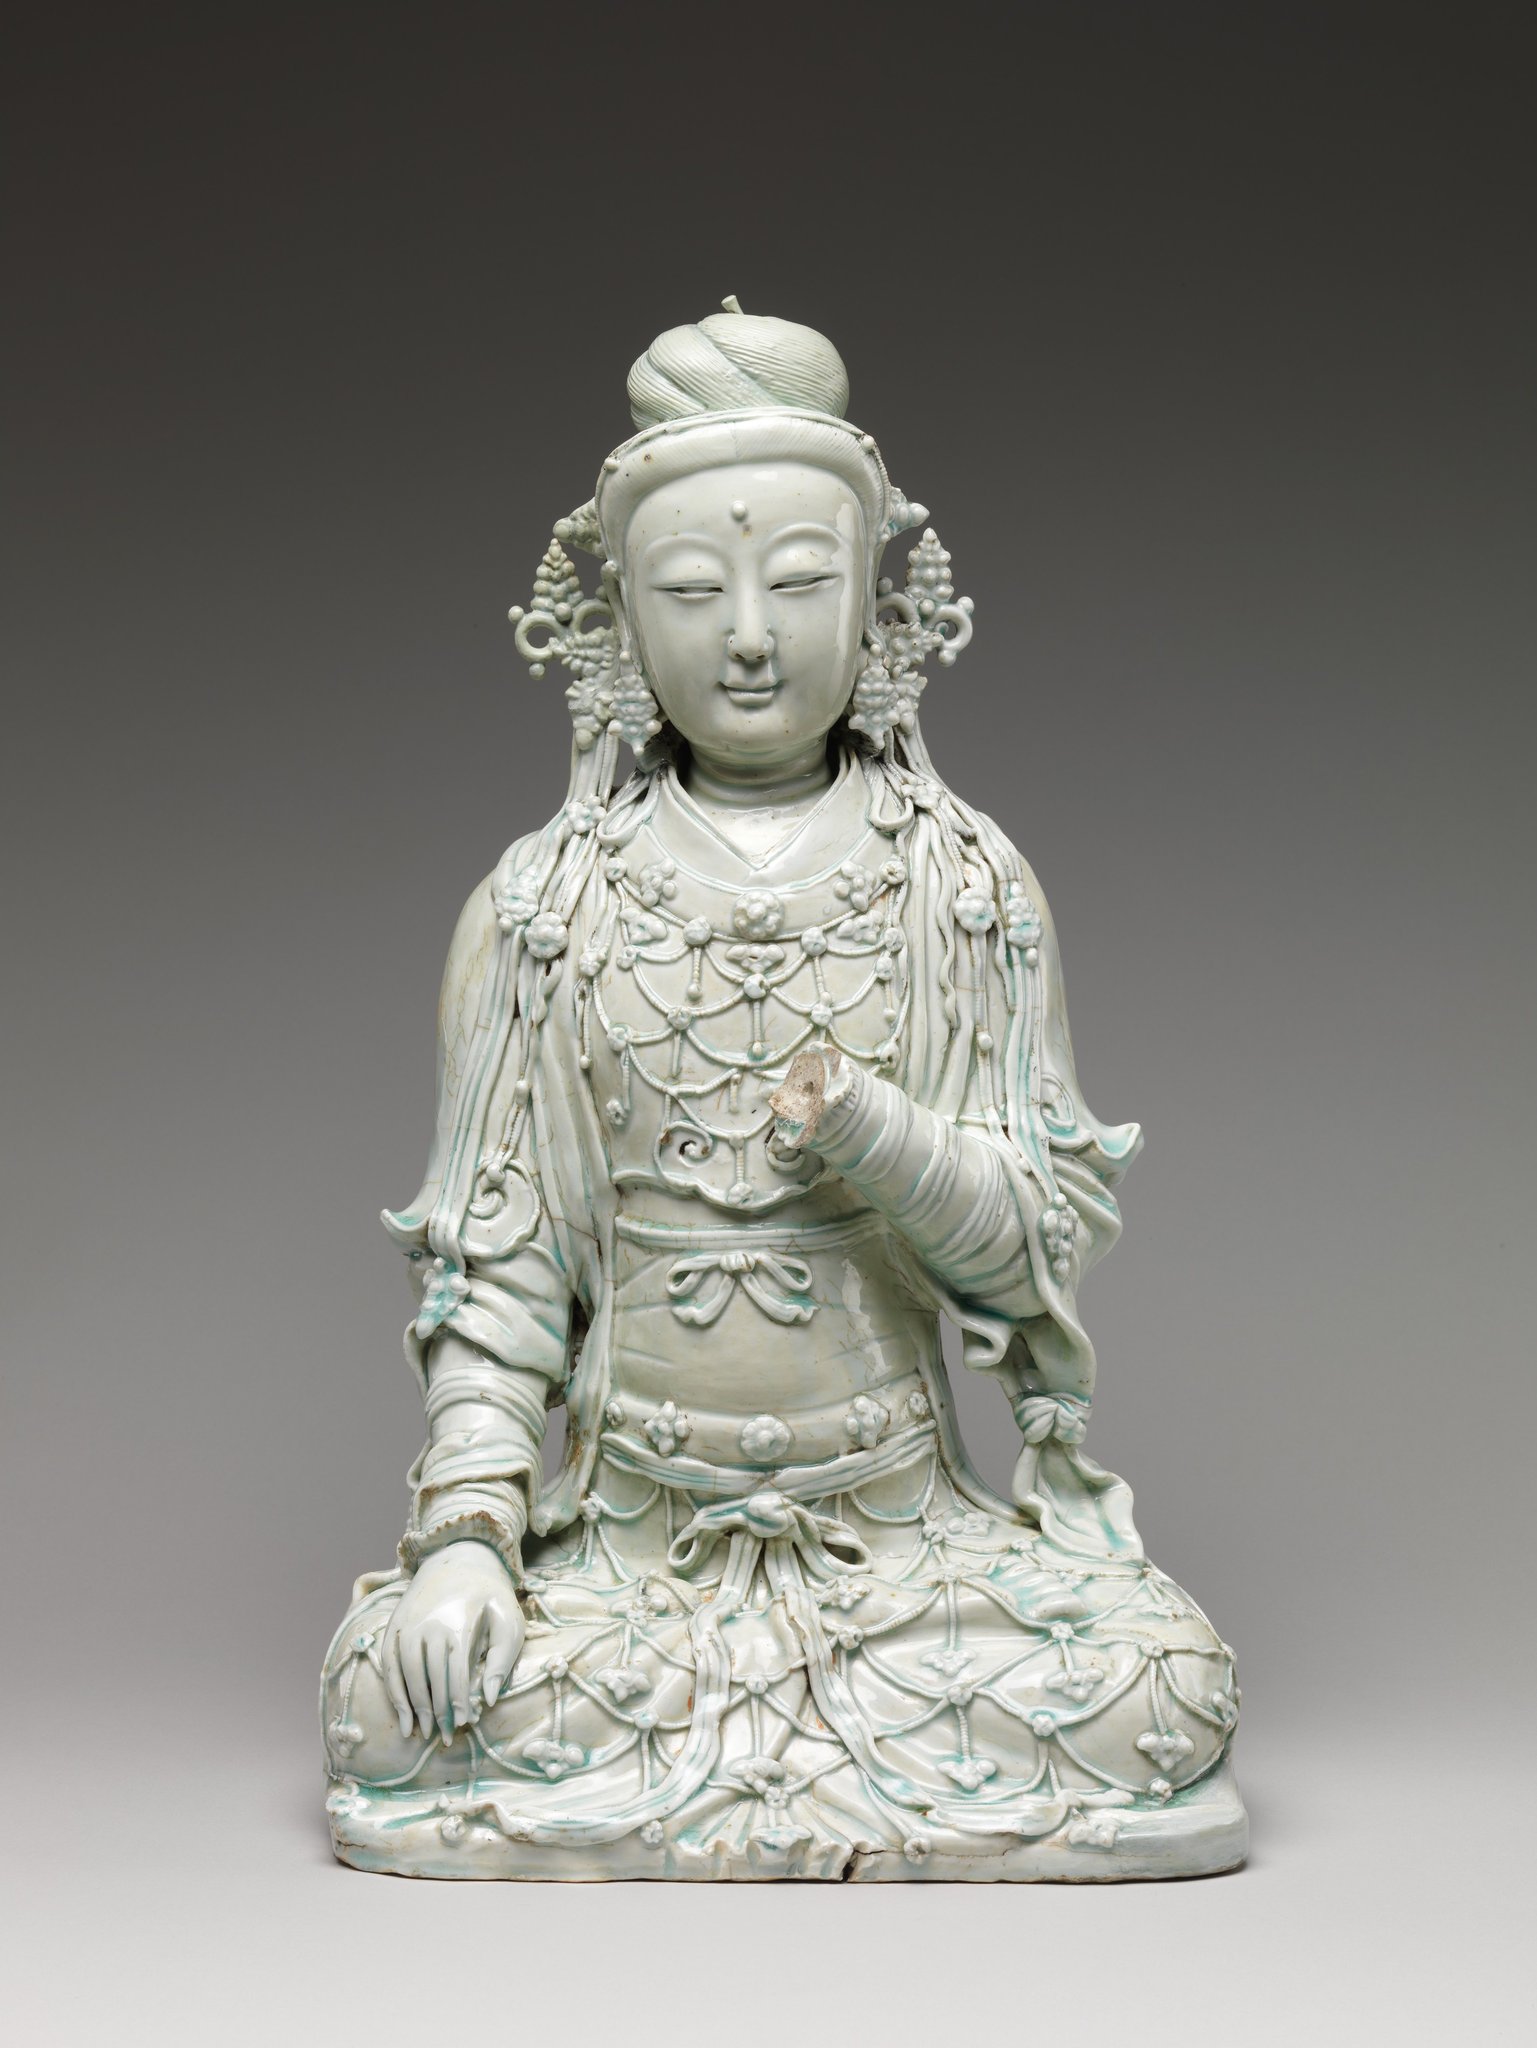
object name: figure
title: Seated bodhisattva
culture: chinese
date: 1267-1333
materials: glaze, porcelain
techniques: relief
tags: buddhism,bodhisattvas